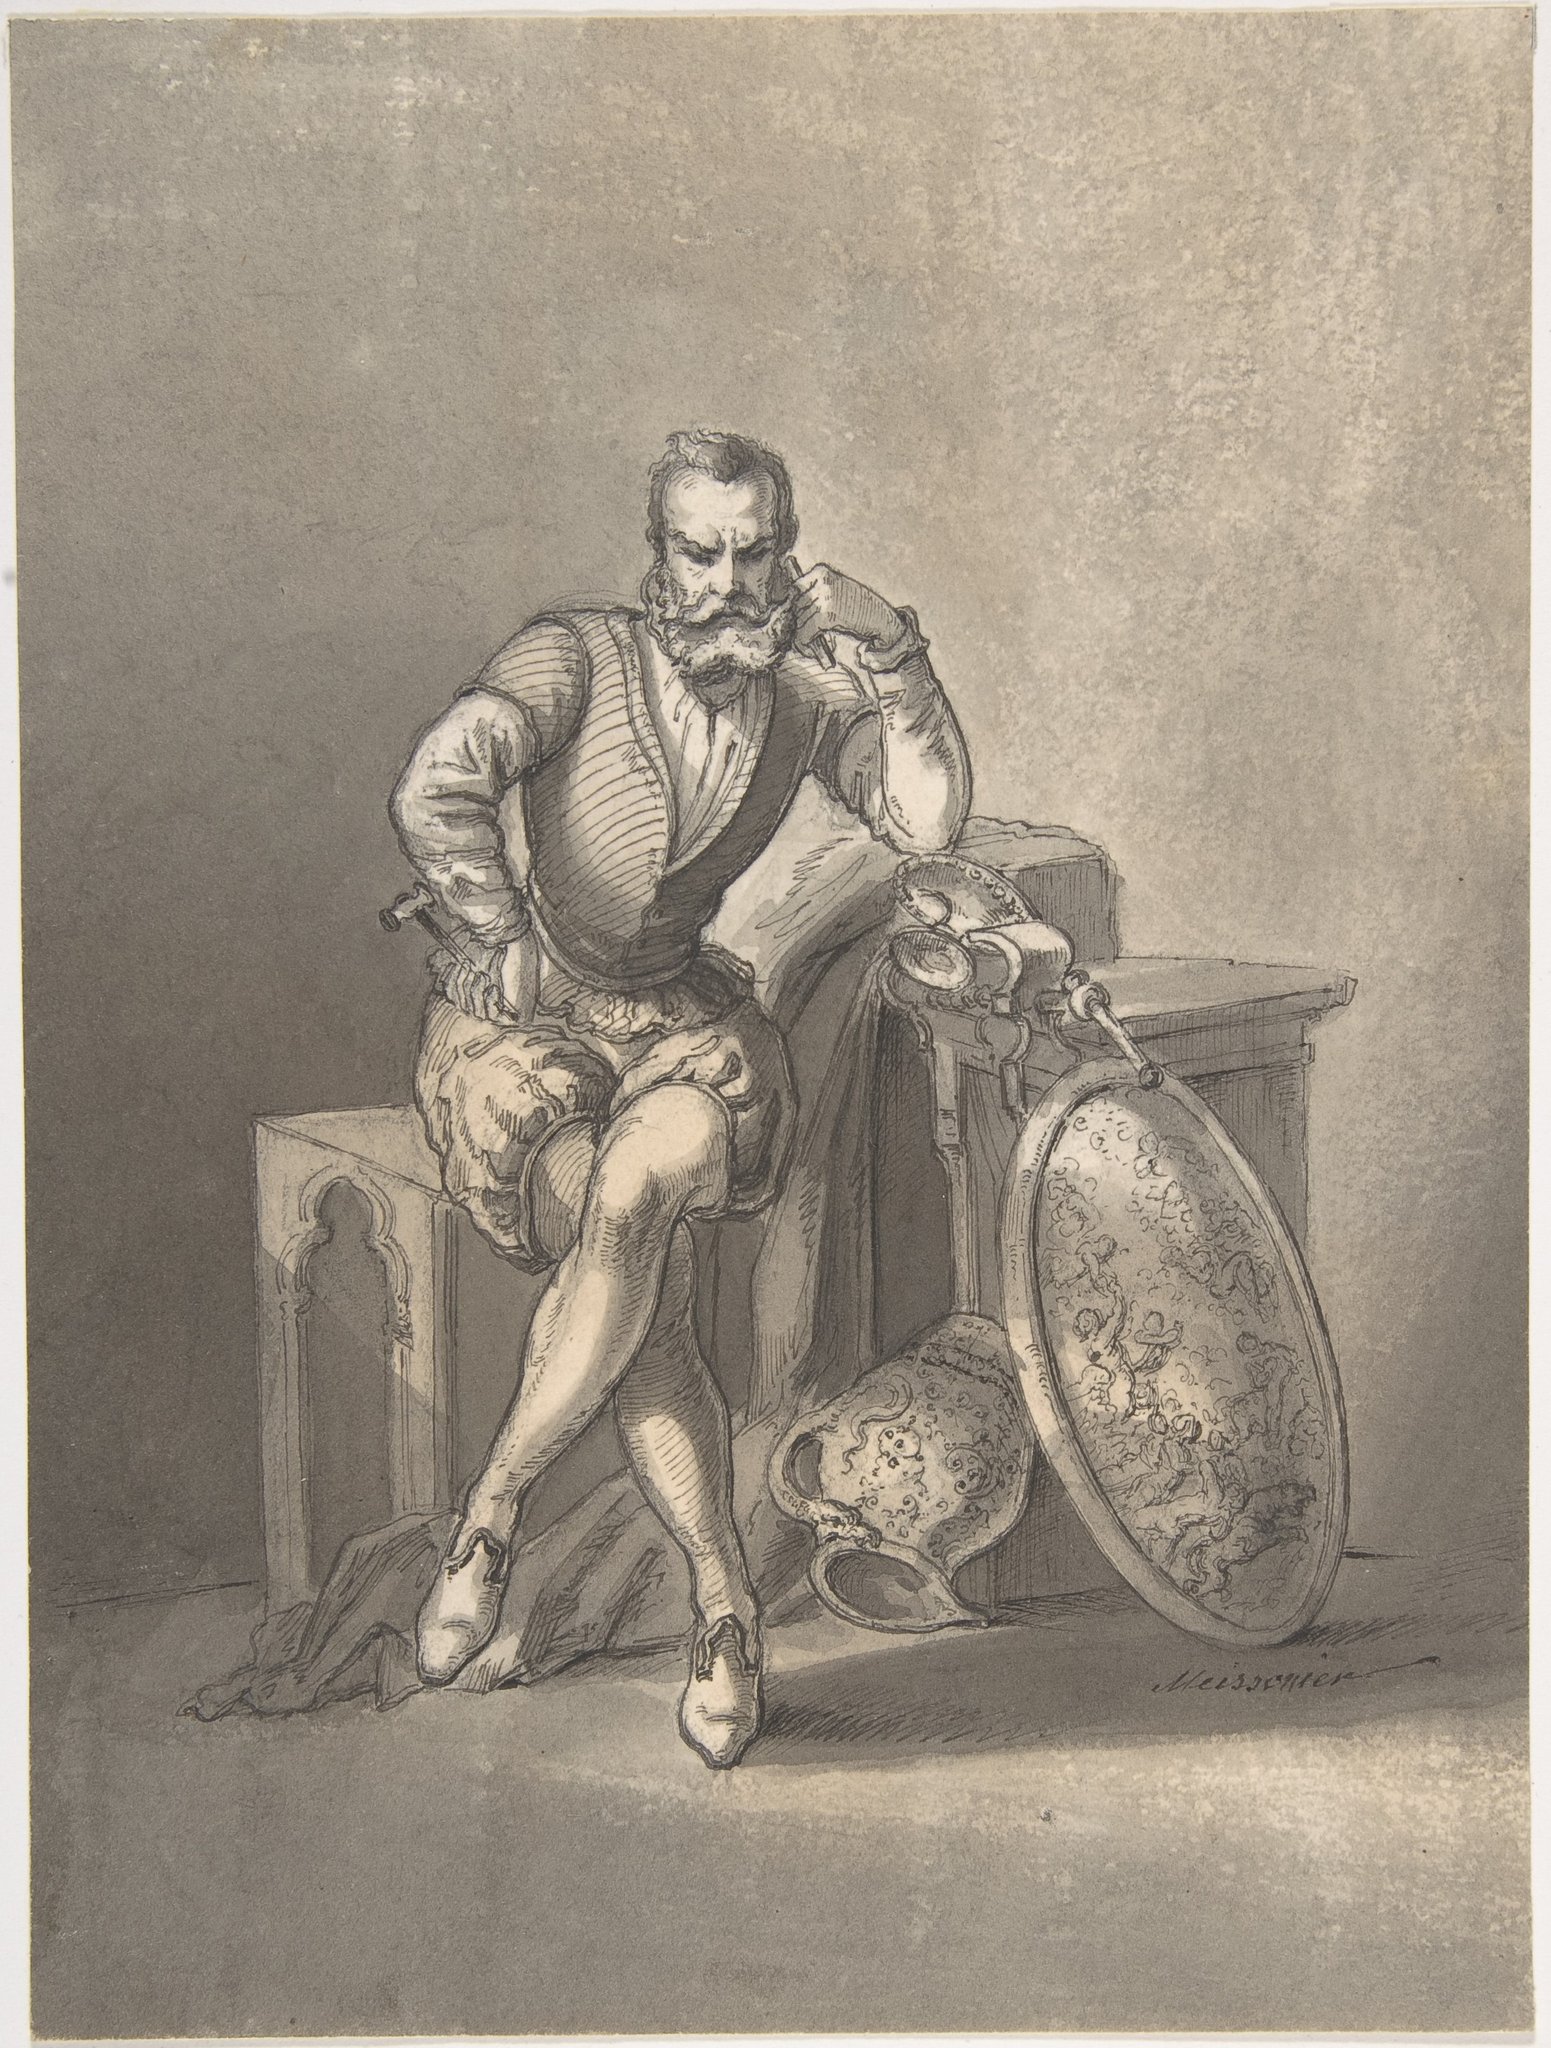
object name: drawing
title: Portrait of a Silversmith, Seated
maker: ernest meissonier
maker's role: artist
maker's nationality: french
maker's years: 1815-1891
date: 1801-1900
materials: ink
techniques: brush, pen, wash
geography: france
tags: men,portraits